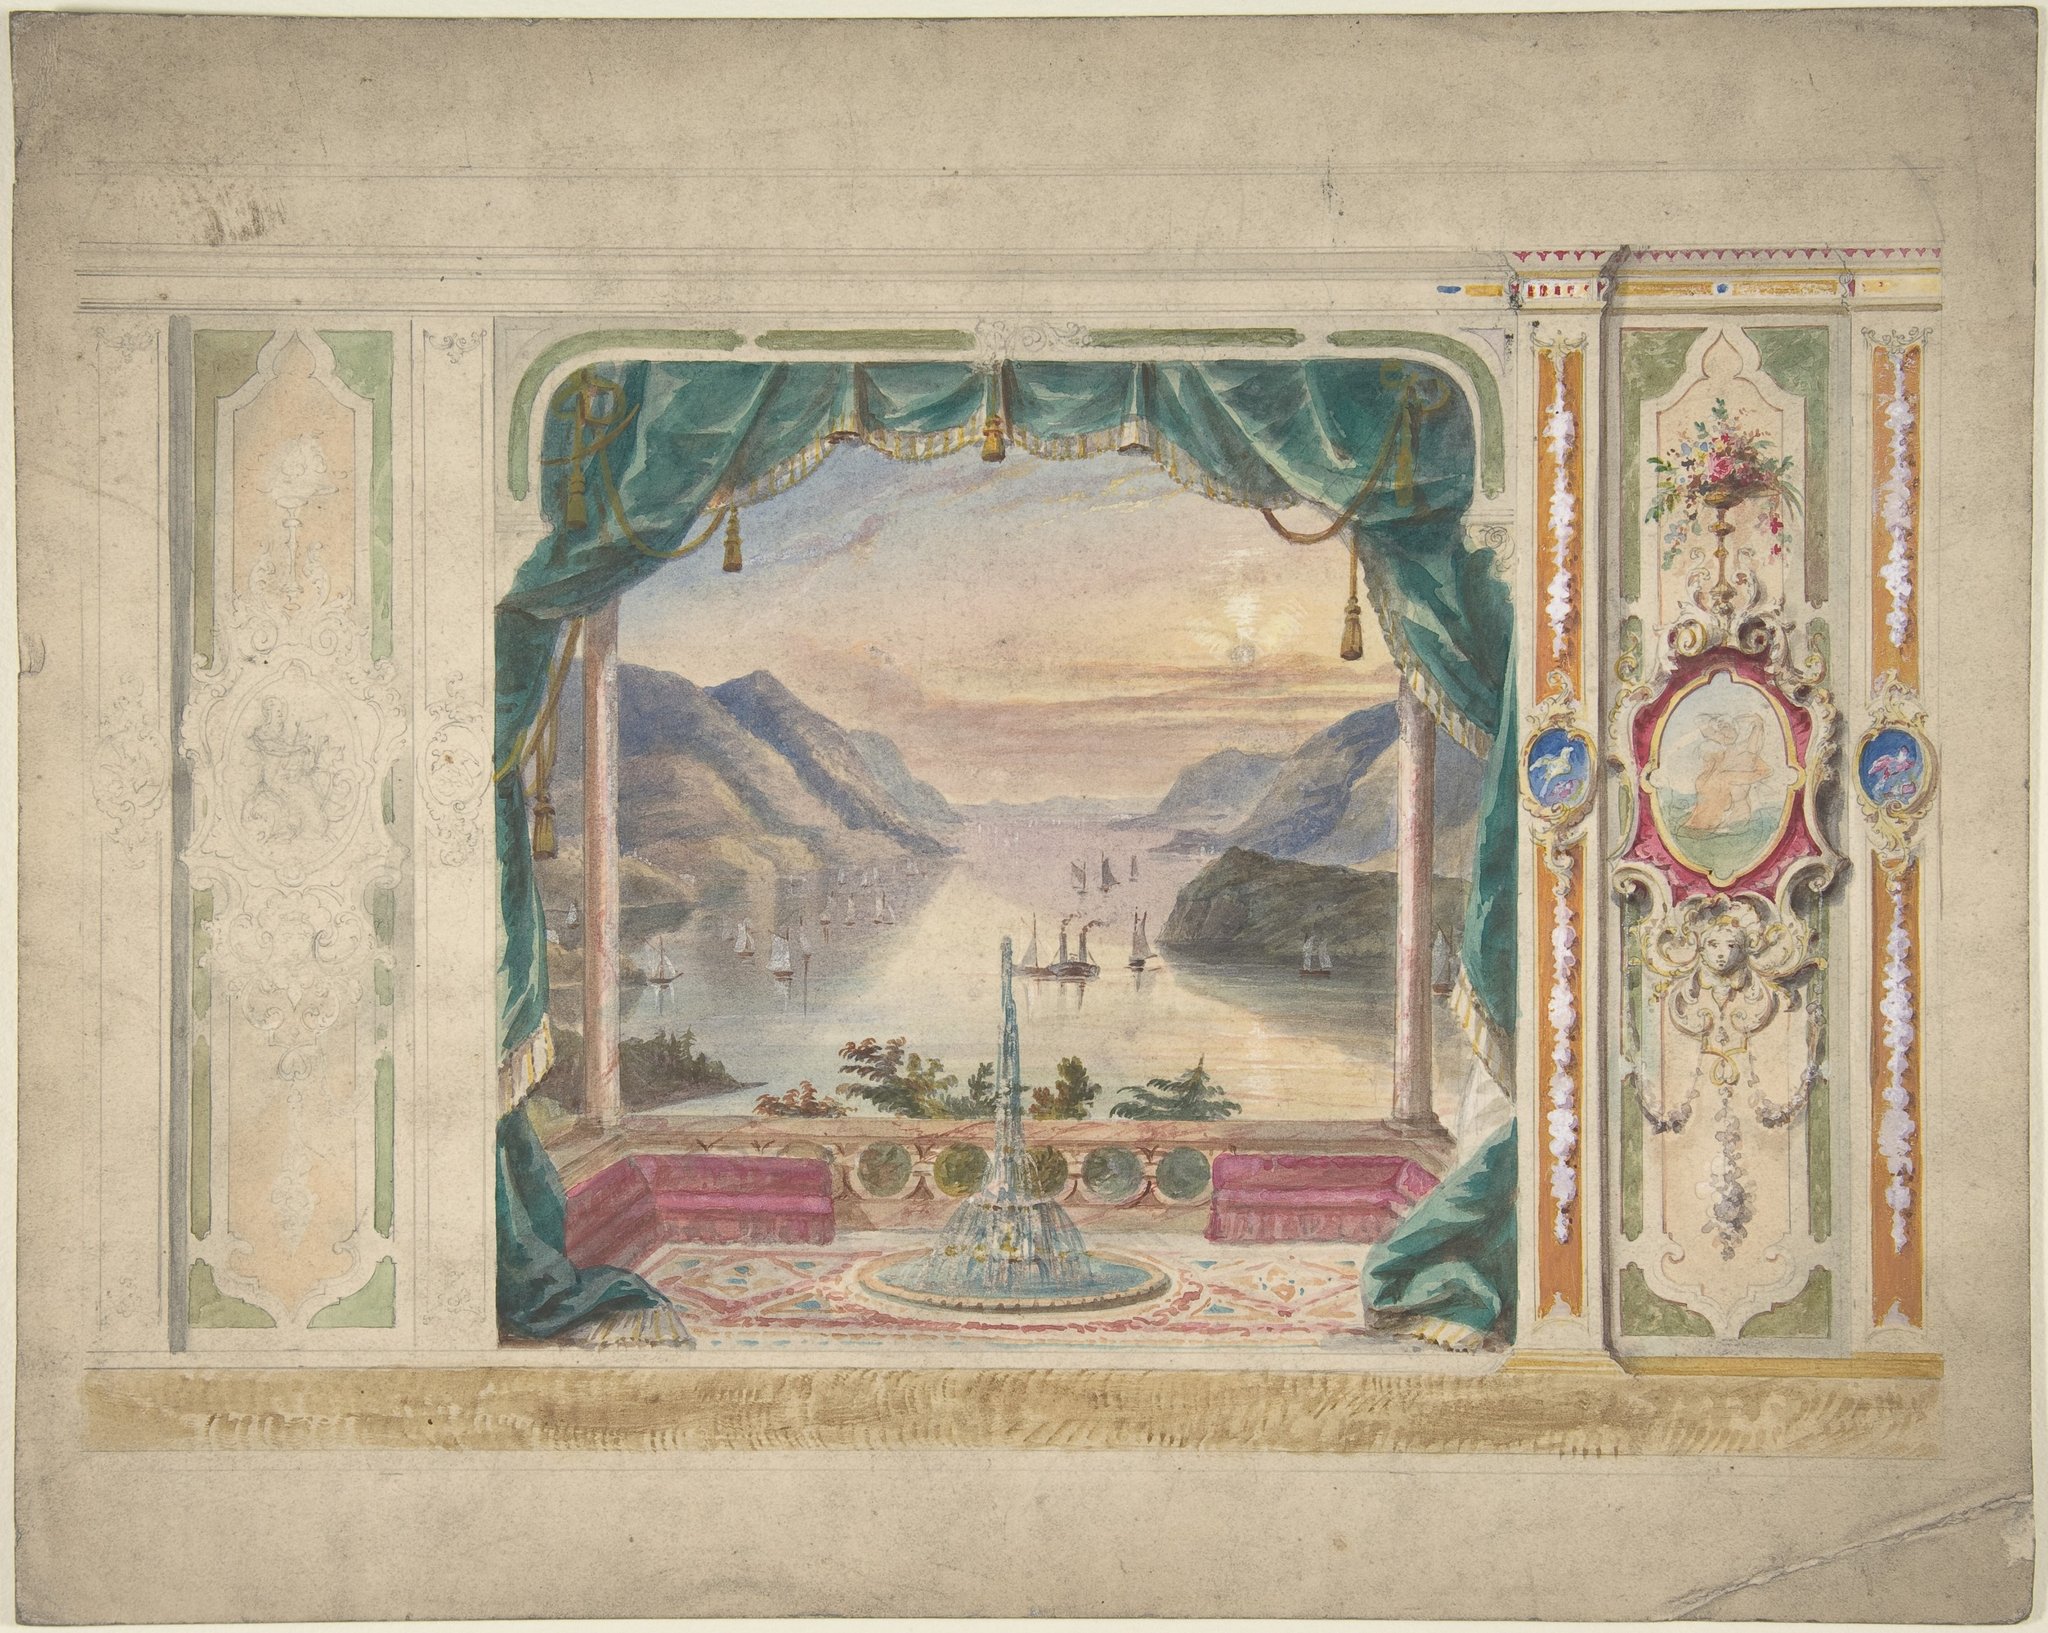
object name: drawing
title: Wall Design with a Trompe l'Oeil Balcony Overlooking a Mountainous Harbor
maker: anonymous, british, 19th century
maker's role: artist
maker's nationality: british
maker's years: 1800-1900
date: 1801-1900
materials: ink, watercolor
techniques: pen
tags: balconies,fountains,mountains